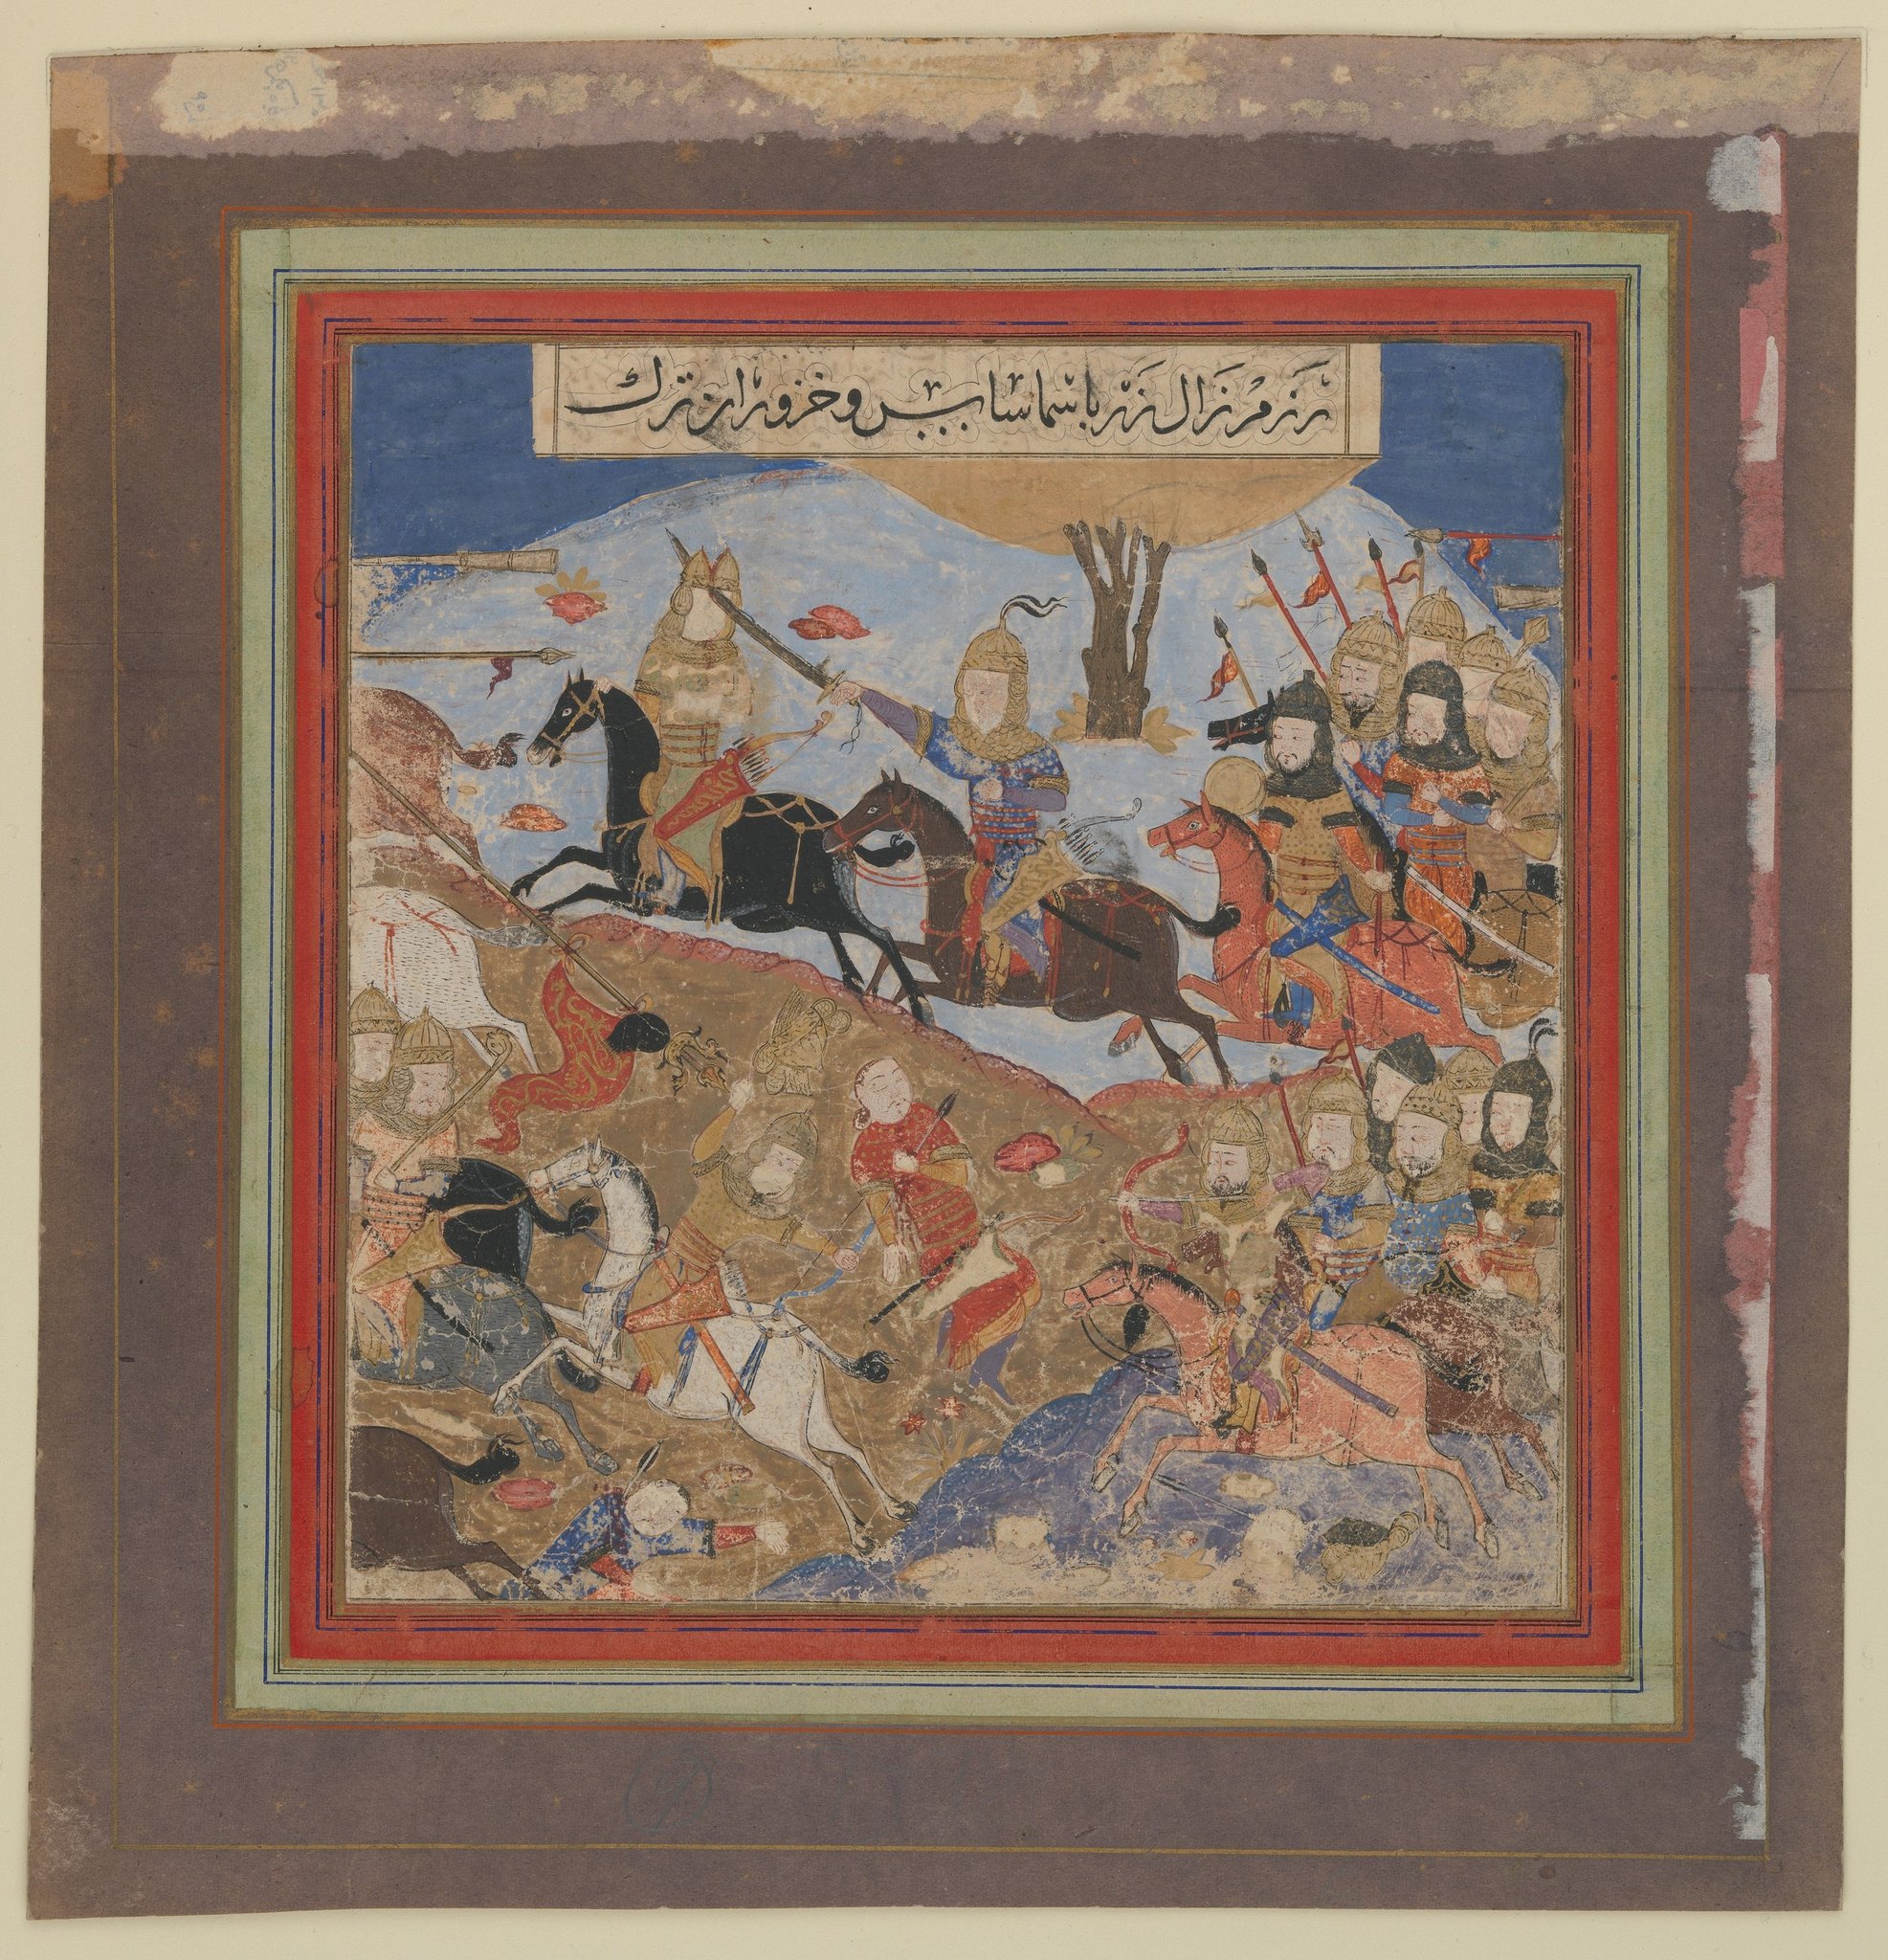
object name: folio from an illustrated manuscript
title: "Zal Slays Khazarvan and Puts Shamasas to Flight", Folio from a Shahnama (Book of Kings)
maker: abu'l qasim firdausi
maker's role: author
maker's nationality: iranian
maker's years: 935-1020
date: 1430-1440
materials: gold, ink, paper, watercolor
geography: india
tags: battles,weapons,men,horses